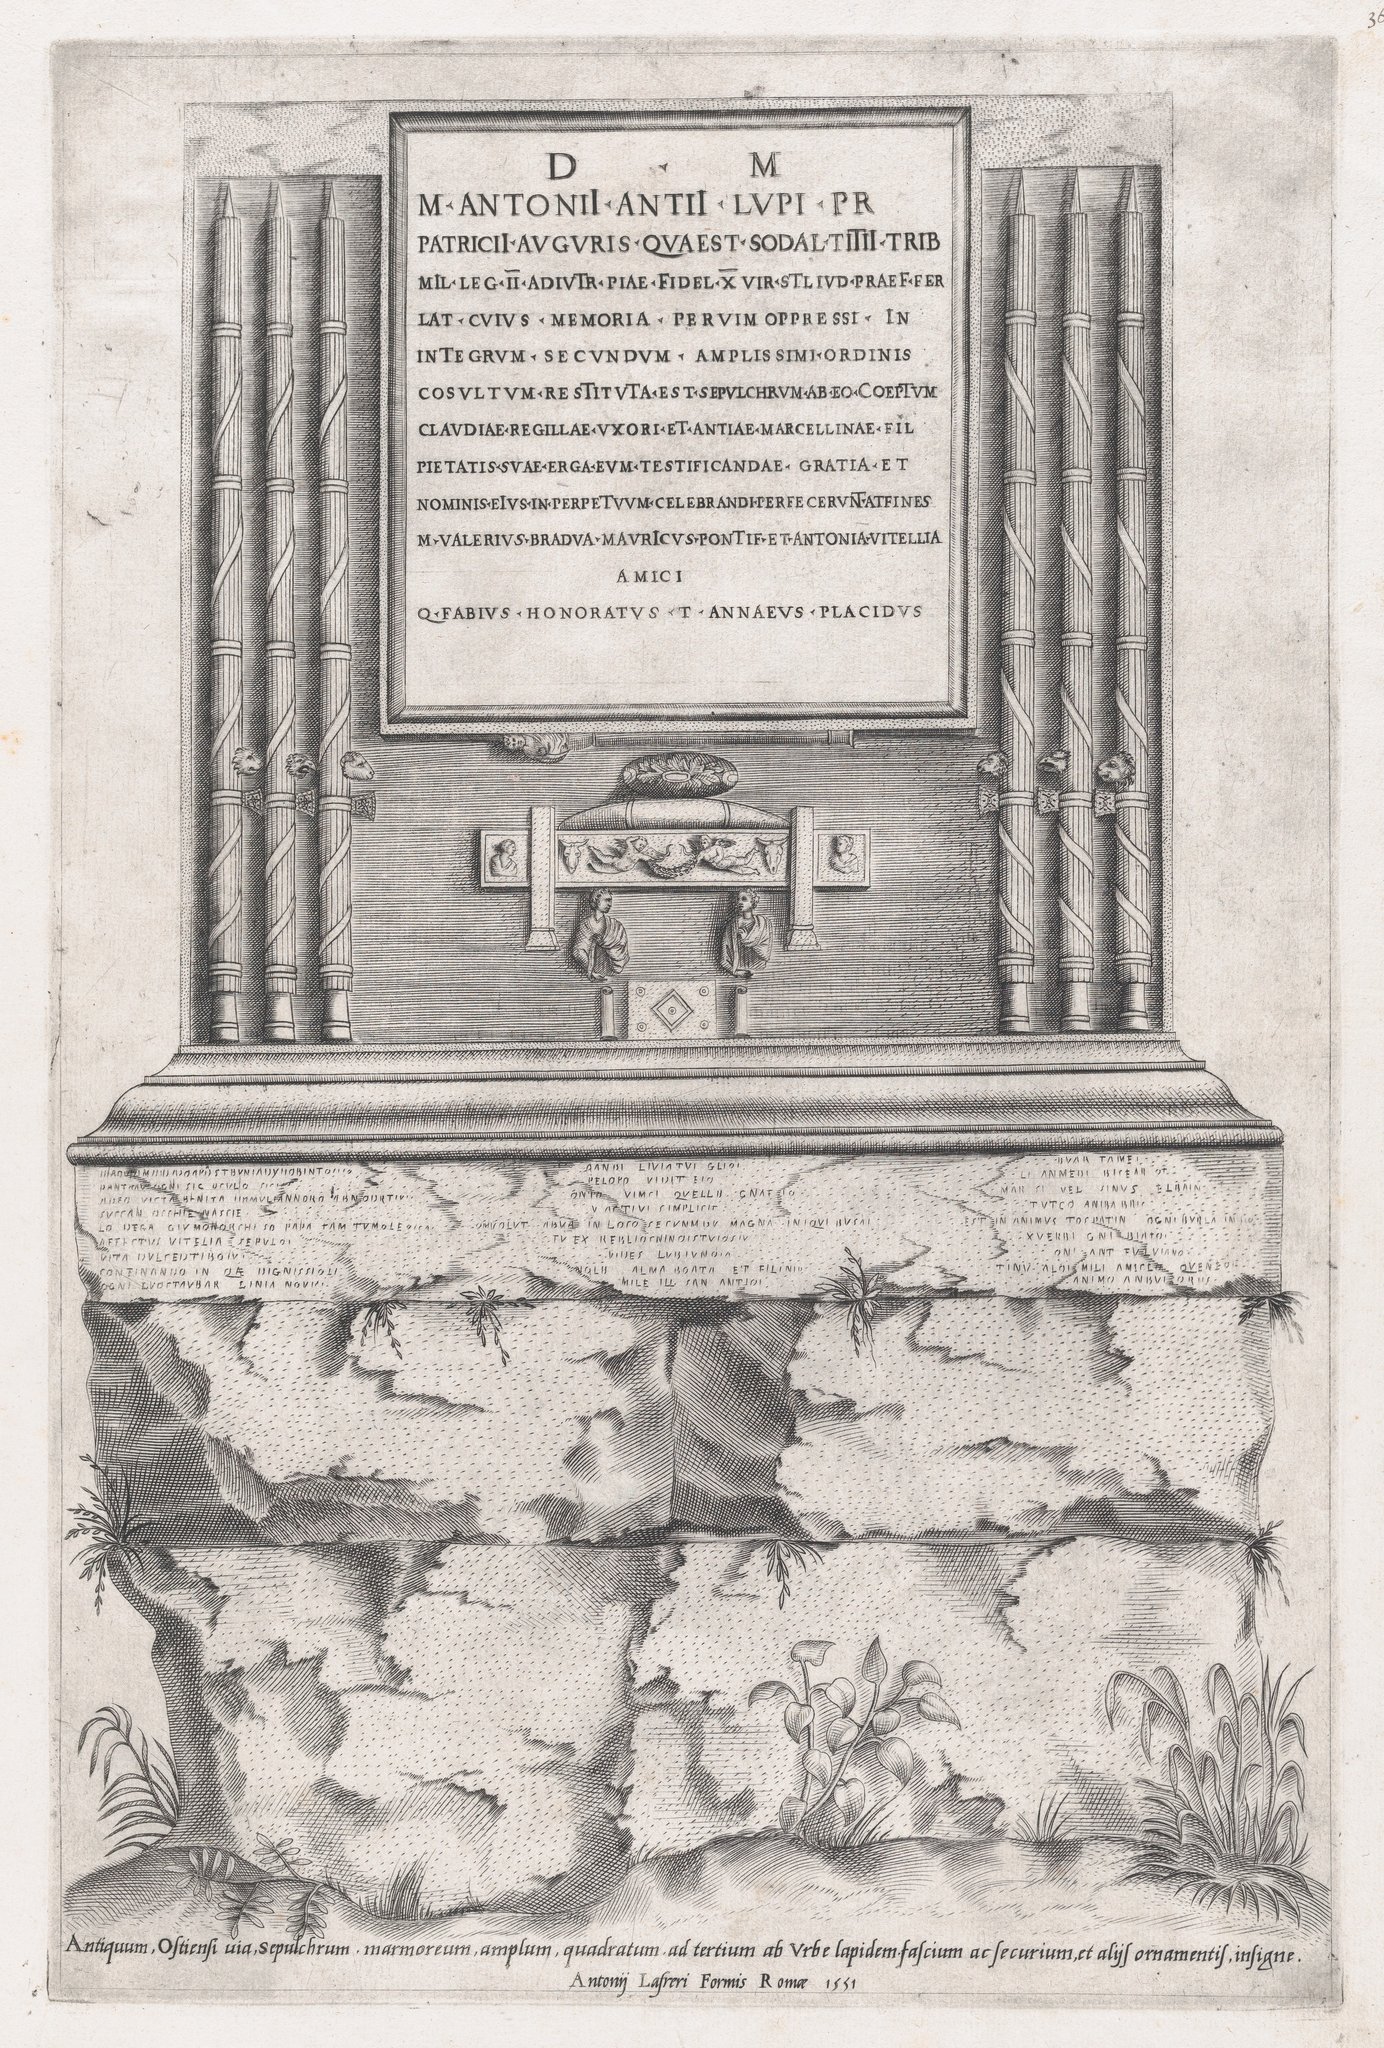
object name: print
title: Sepulchre of Lupus, from "Speculum Romanae Magnificentiae"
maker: Anonymous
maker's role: artist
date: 1551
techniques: engraving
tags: tombs,burial grounds,rome